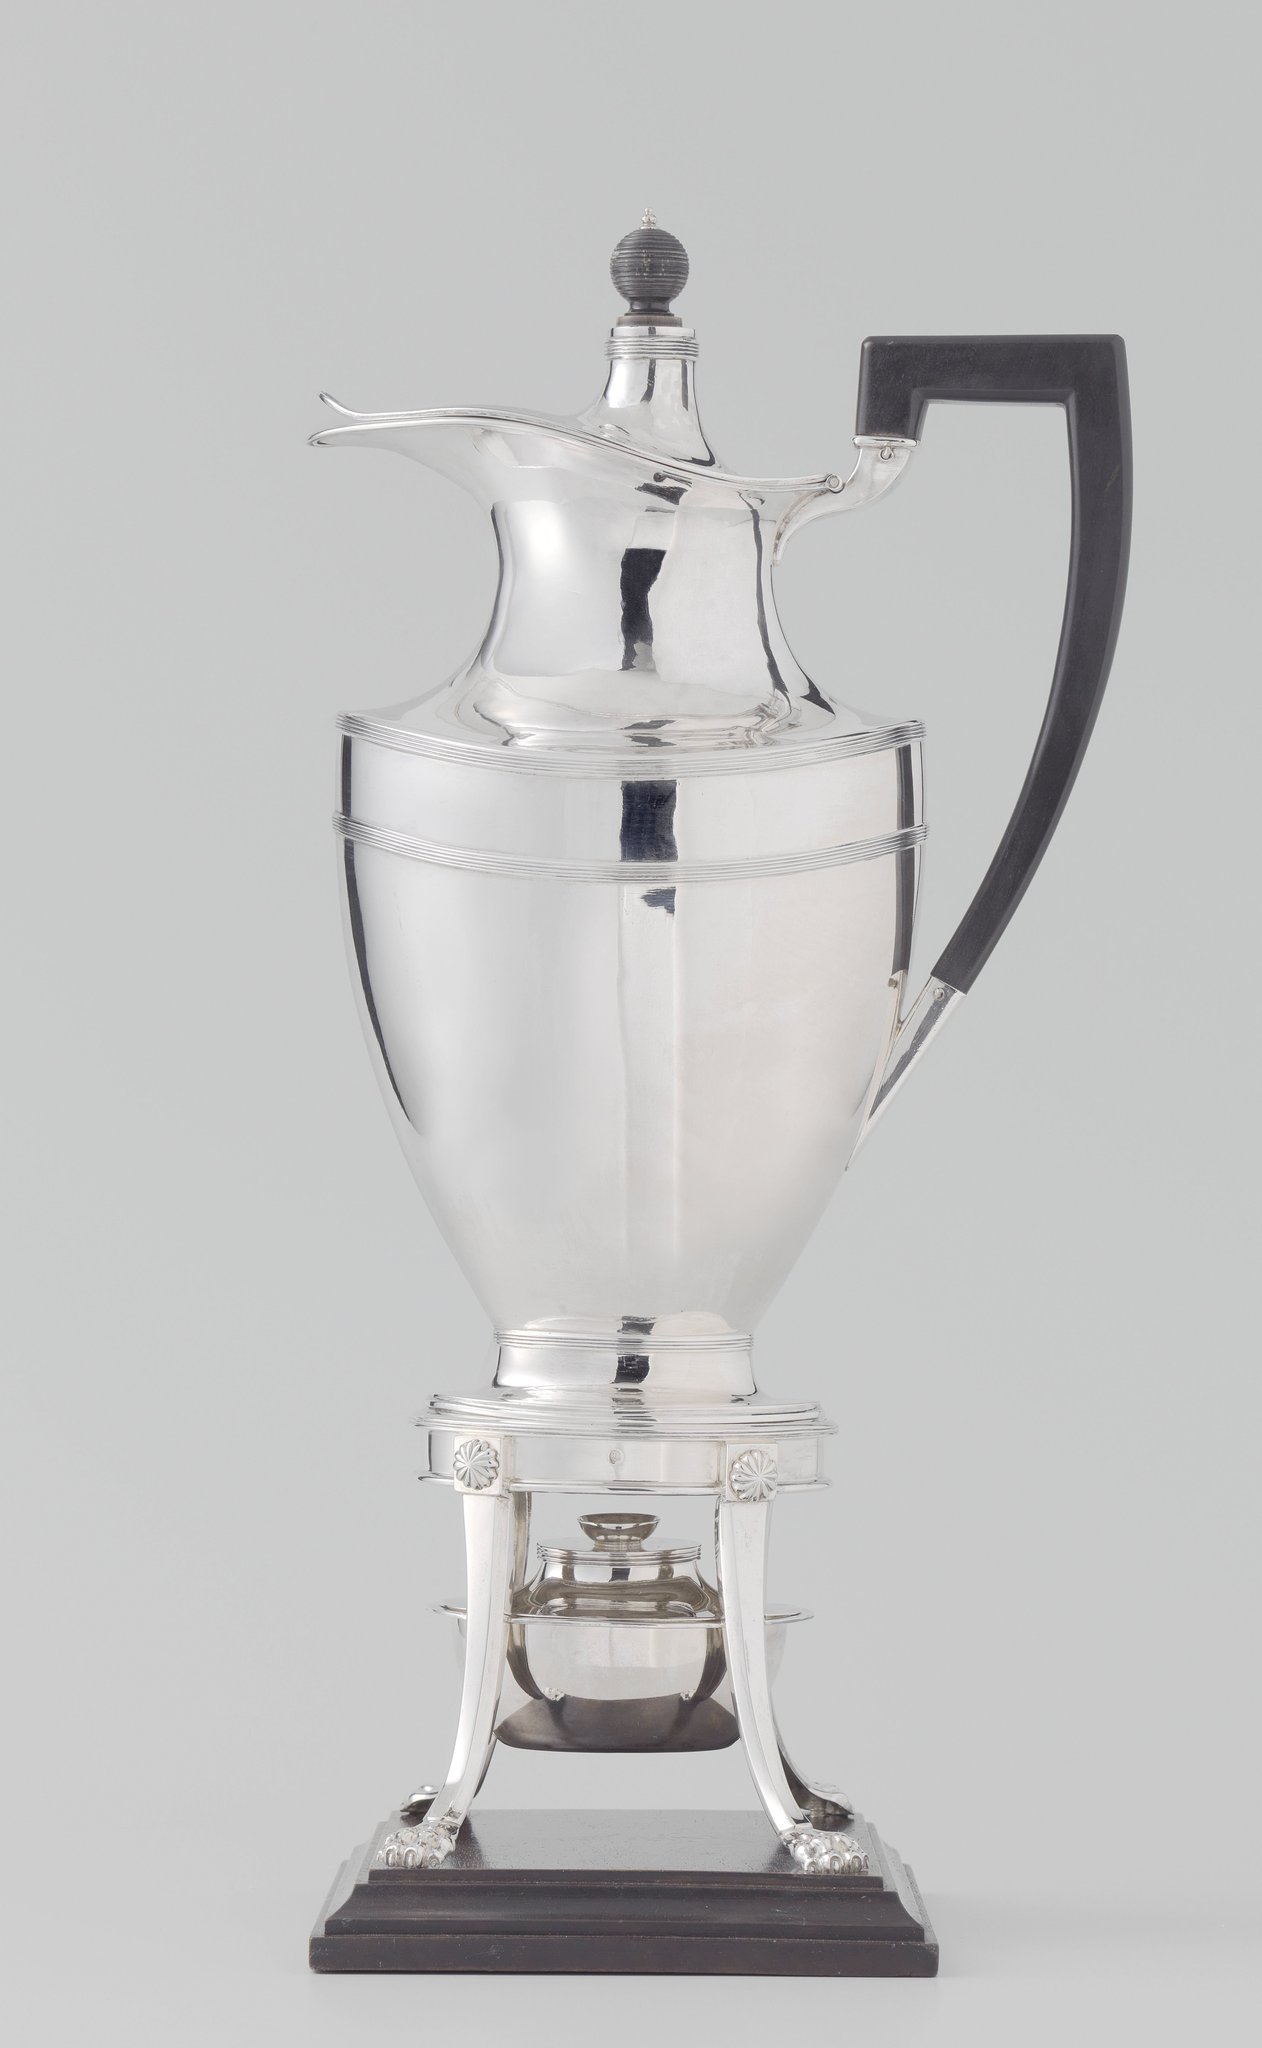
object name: komfoor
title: Coffee pot with stand and burner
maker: diederik lodewijk bennewitz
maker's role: silversmith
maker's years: 1763-1826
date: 1815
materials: wood, silver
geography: amsterdam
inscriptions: date letter: ‘F’, assay office mark, maker's mark, hallmark: ‘zwaardje’, alloy mark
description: De gewelfde voet van de ovale kan (A) rust op een getrapte basis. Het vaasvormige lichaam loopt aan de zijkanten iets hoger op. De gewelfde, zich verjongende hals gaat aan één zijde over in de schenktuit, aan de andere zijde in een recht gedeelte, waar het scharnier van het deksel bevestigd is. Het gewelfde deksel rijst in het midden hoog op en heeft een geribde, bolvormige ebbenhouten knop, bekroond door een klein zilveren knopje. Het ebbenhouten oor, vierhoekig in doorsnede, vertoont aan de bovenzijde twee rechte hoeken en heeft zilveren vattingen. Langs de bovenzijde van de voet, langs de bovenzijde van het lichaam, en eveneens op ongeveer 1,5 cm daaronder, en langs de buitenrand en het bovenstuk van het deksel lopen filetranden. De basis van de kan past in de standring van het komfoor (B), die gedragen wordt door vier gebogen poten eindigend in leeuwenklauwen en bekroond door vierkante velden met rozetten. Langs de bovenzijde van de ring loopt een samengestelde profiellijst en langs de onderzijde een enkel profiel. De poten zijn verbonden door een gladde ring, waarin de losse, komvormige brander rust. De brander heeft een los deksel met in het midden een opening en een houder voor de lont. Langs de lage wand van het deksel loopt een filetrand. Het komfoor rust op een rechthoekige ebbenhouten onderplaat met geprofileerde zijkanten.